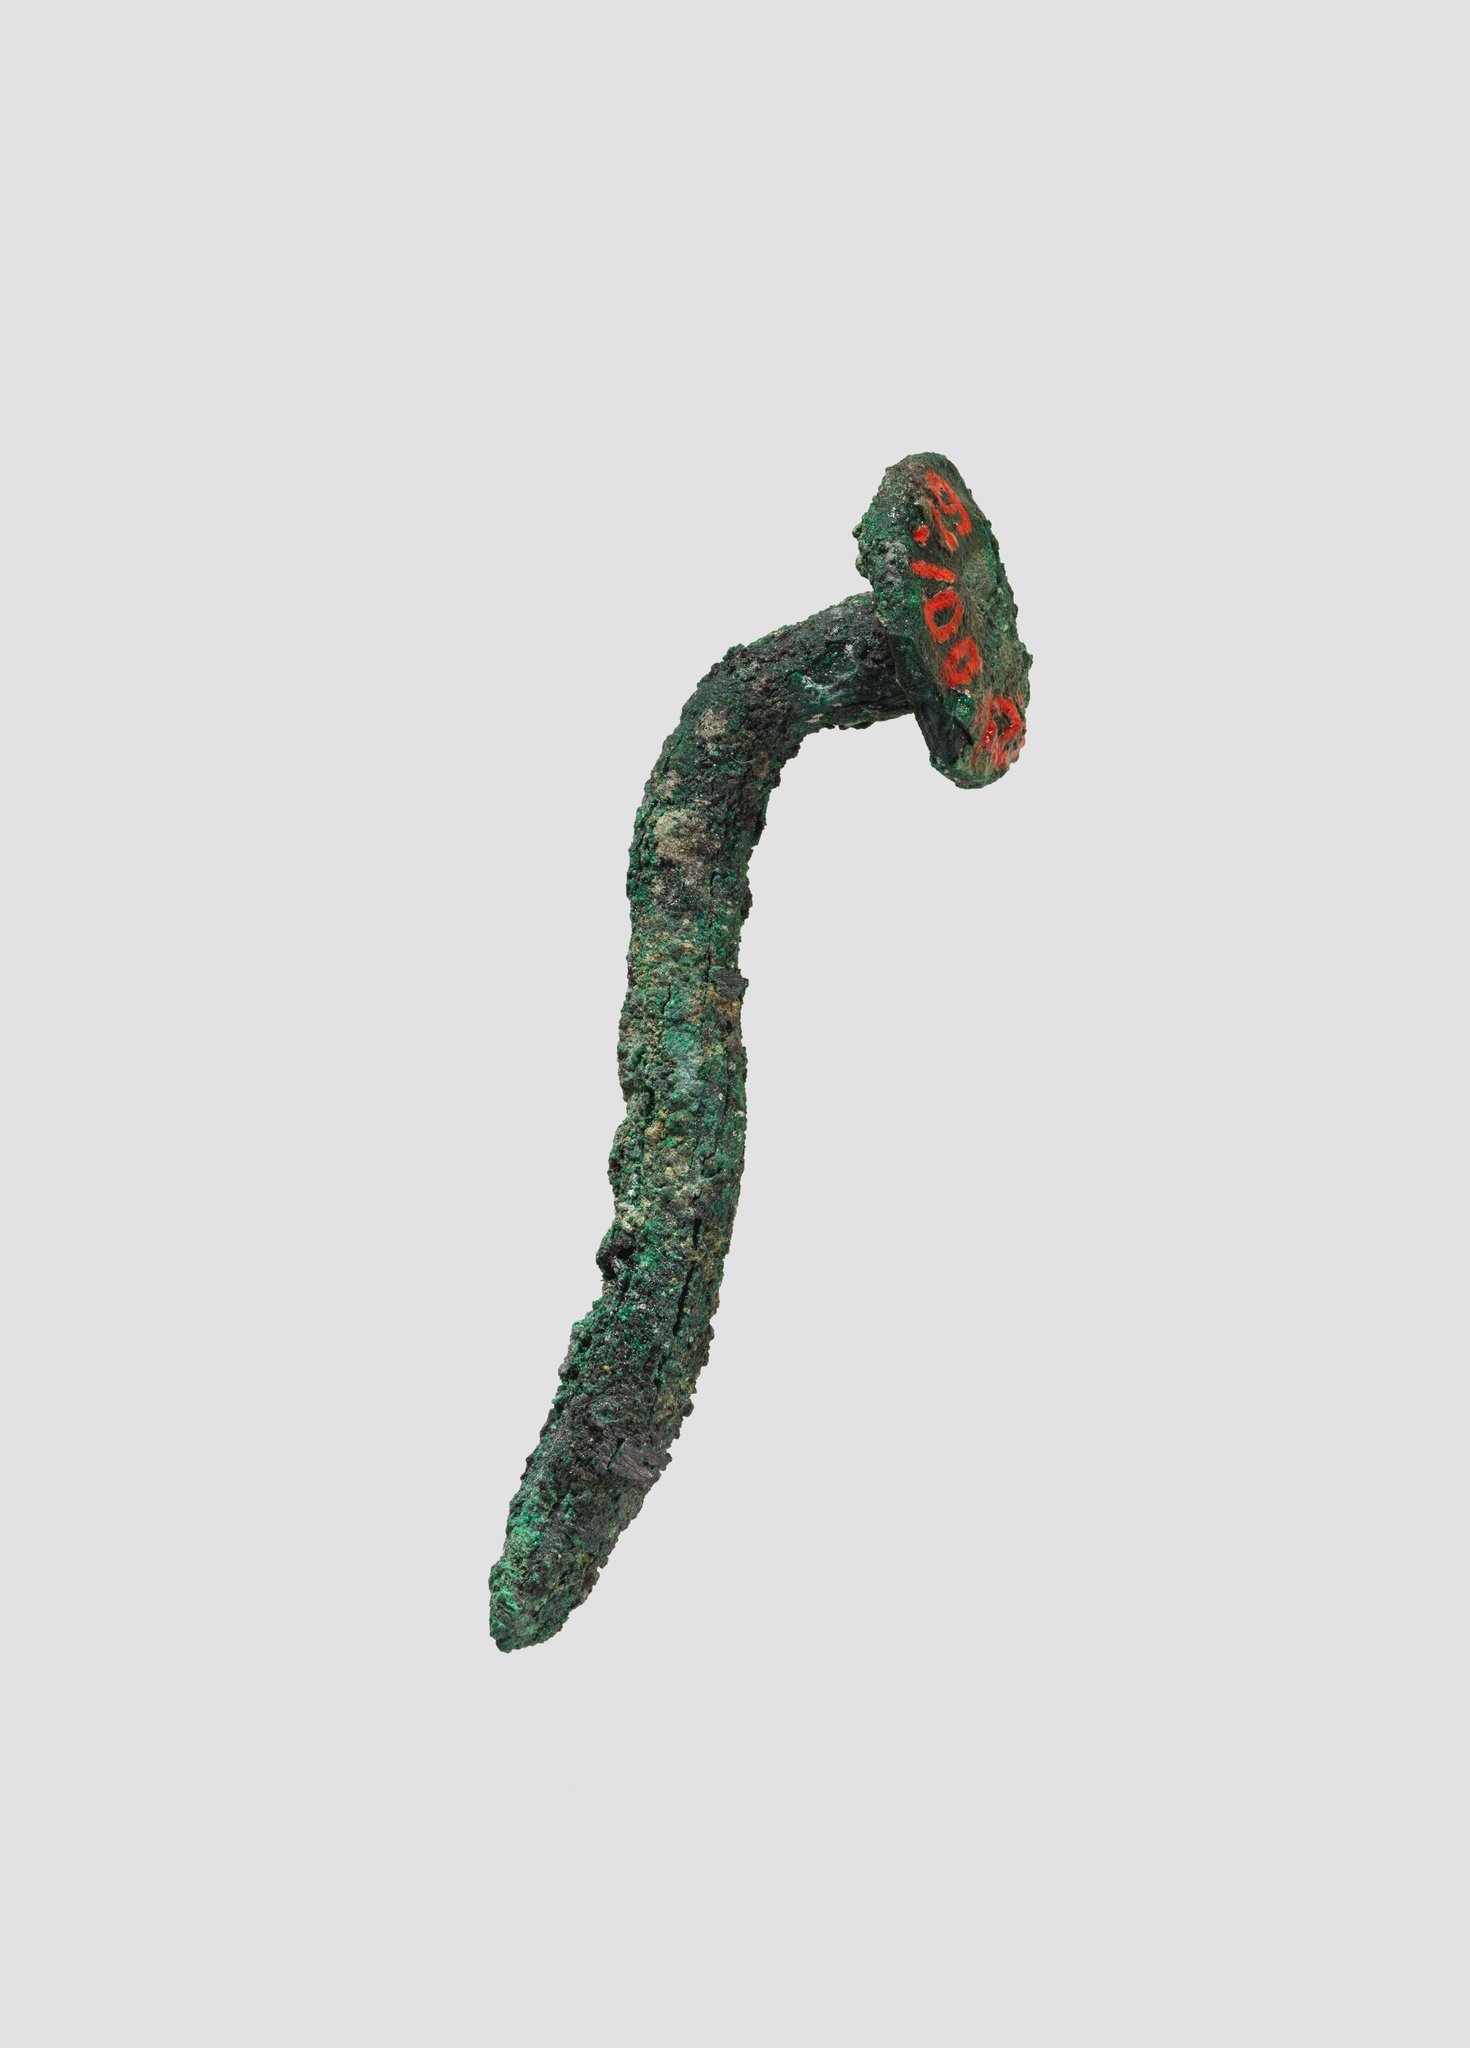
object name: nail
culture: iranian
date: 900-801 BCE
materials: bronze, copper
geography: iran